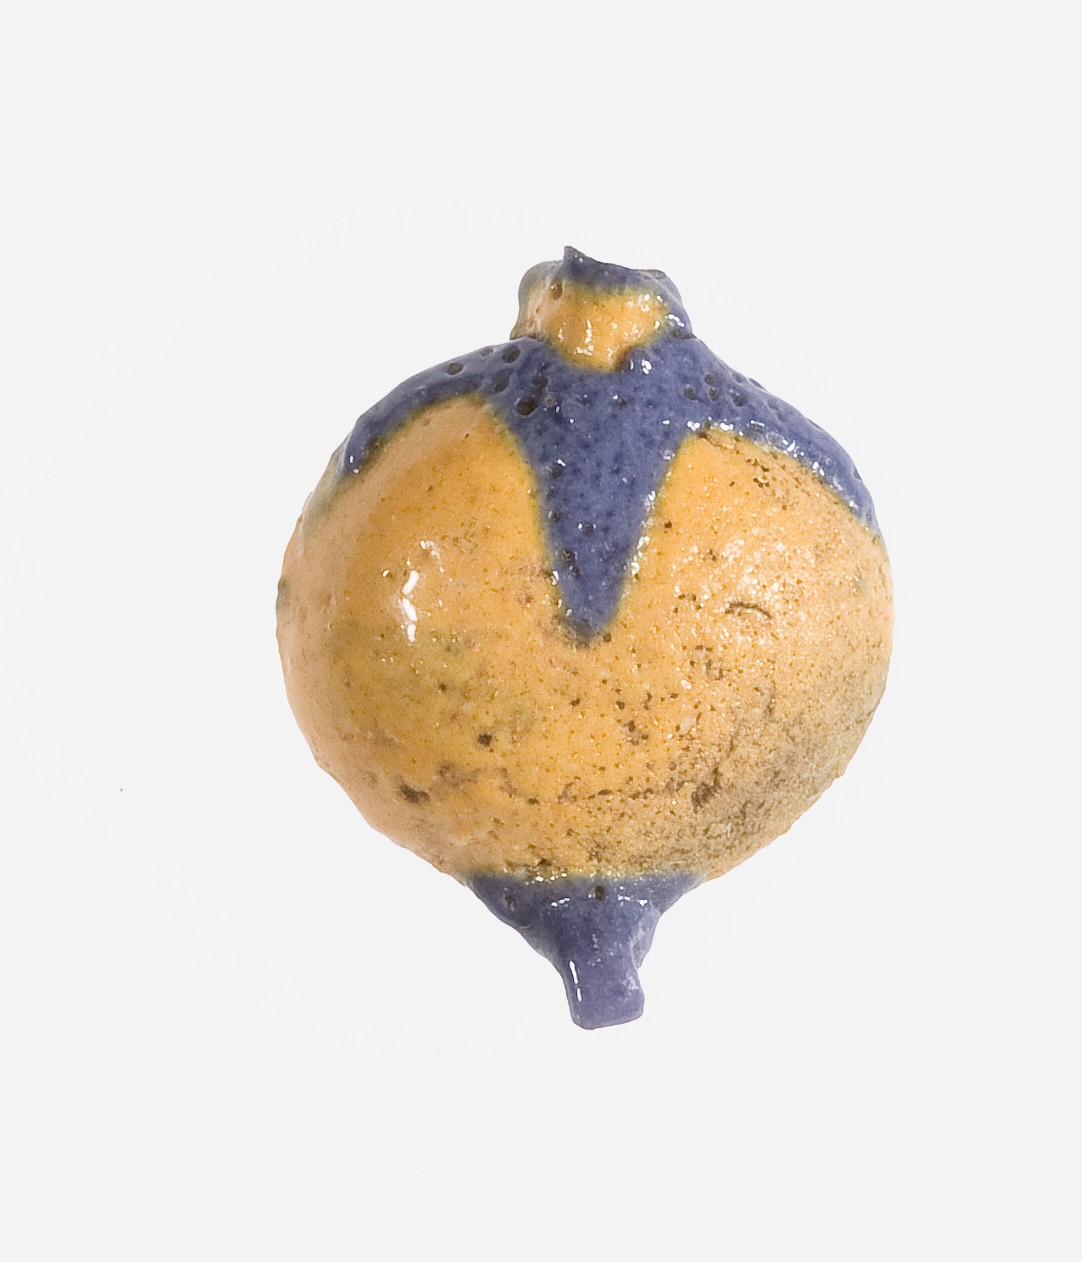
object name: bead, persea fruit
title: Bead in the Form of a Persea Fruit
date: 1390-1352 BCE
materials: faience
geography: egypt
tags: fruit